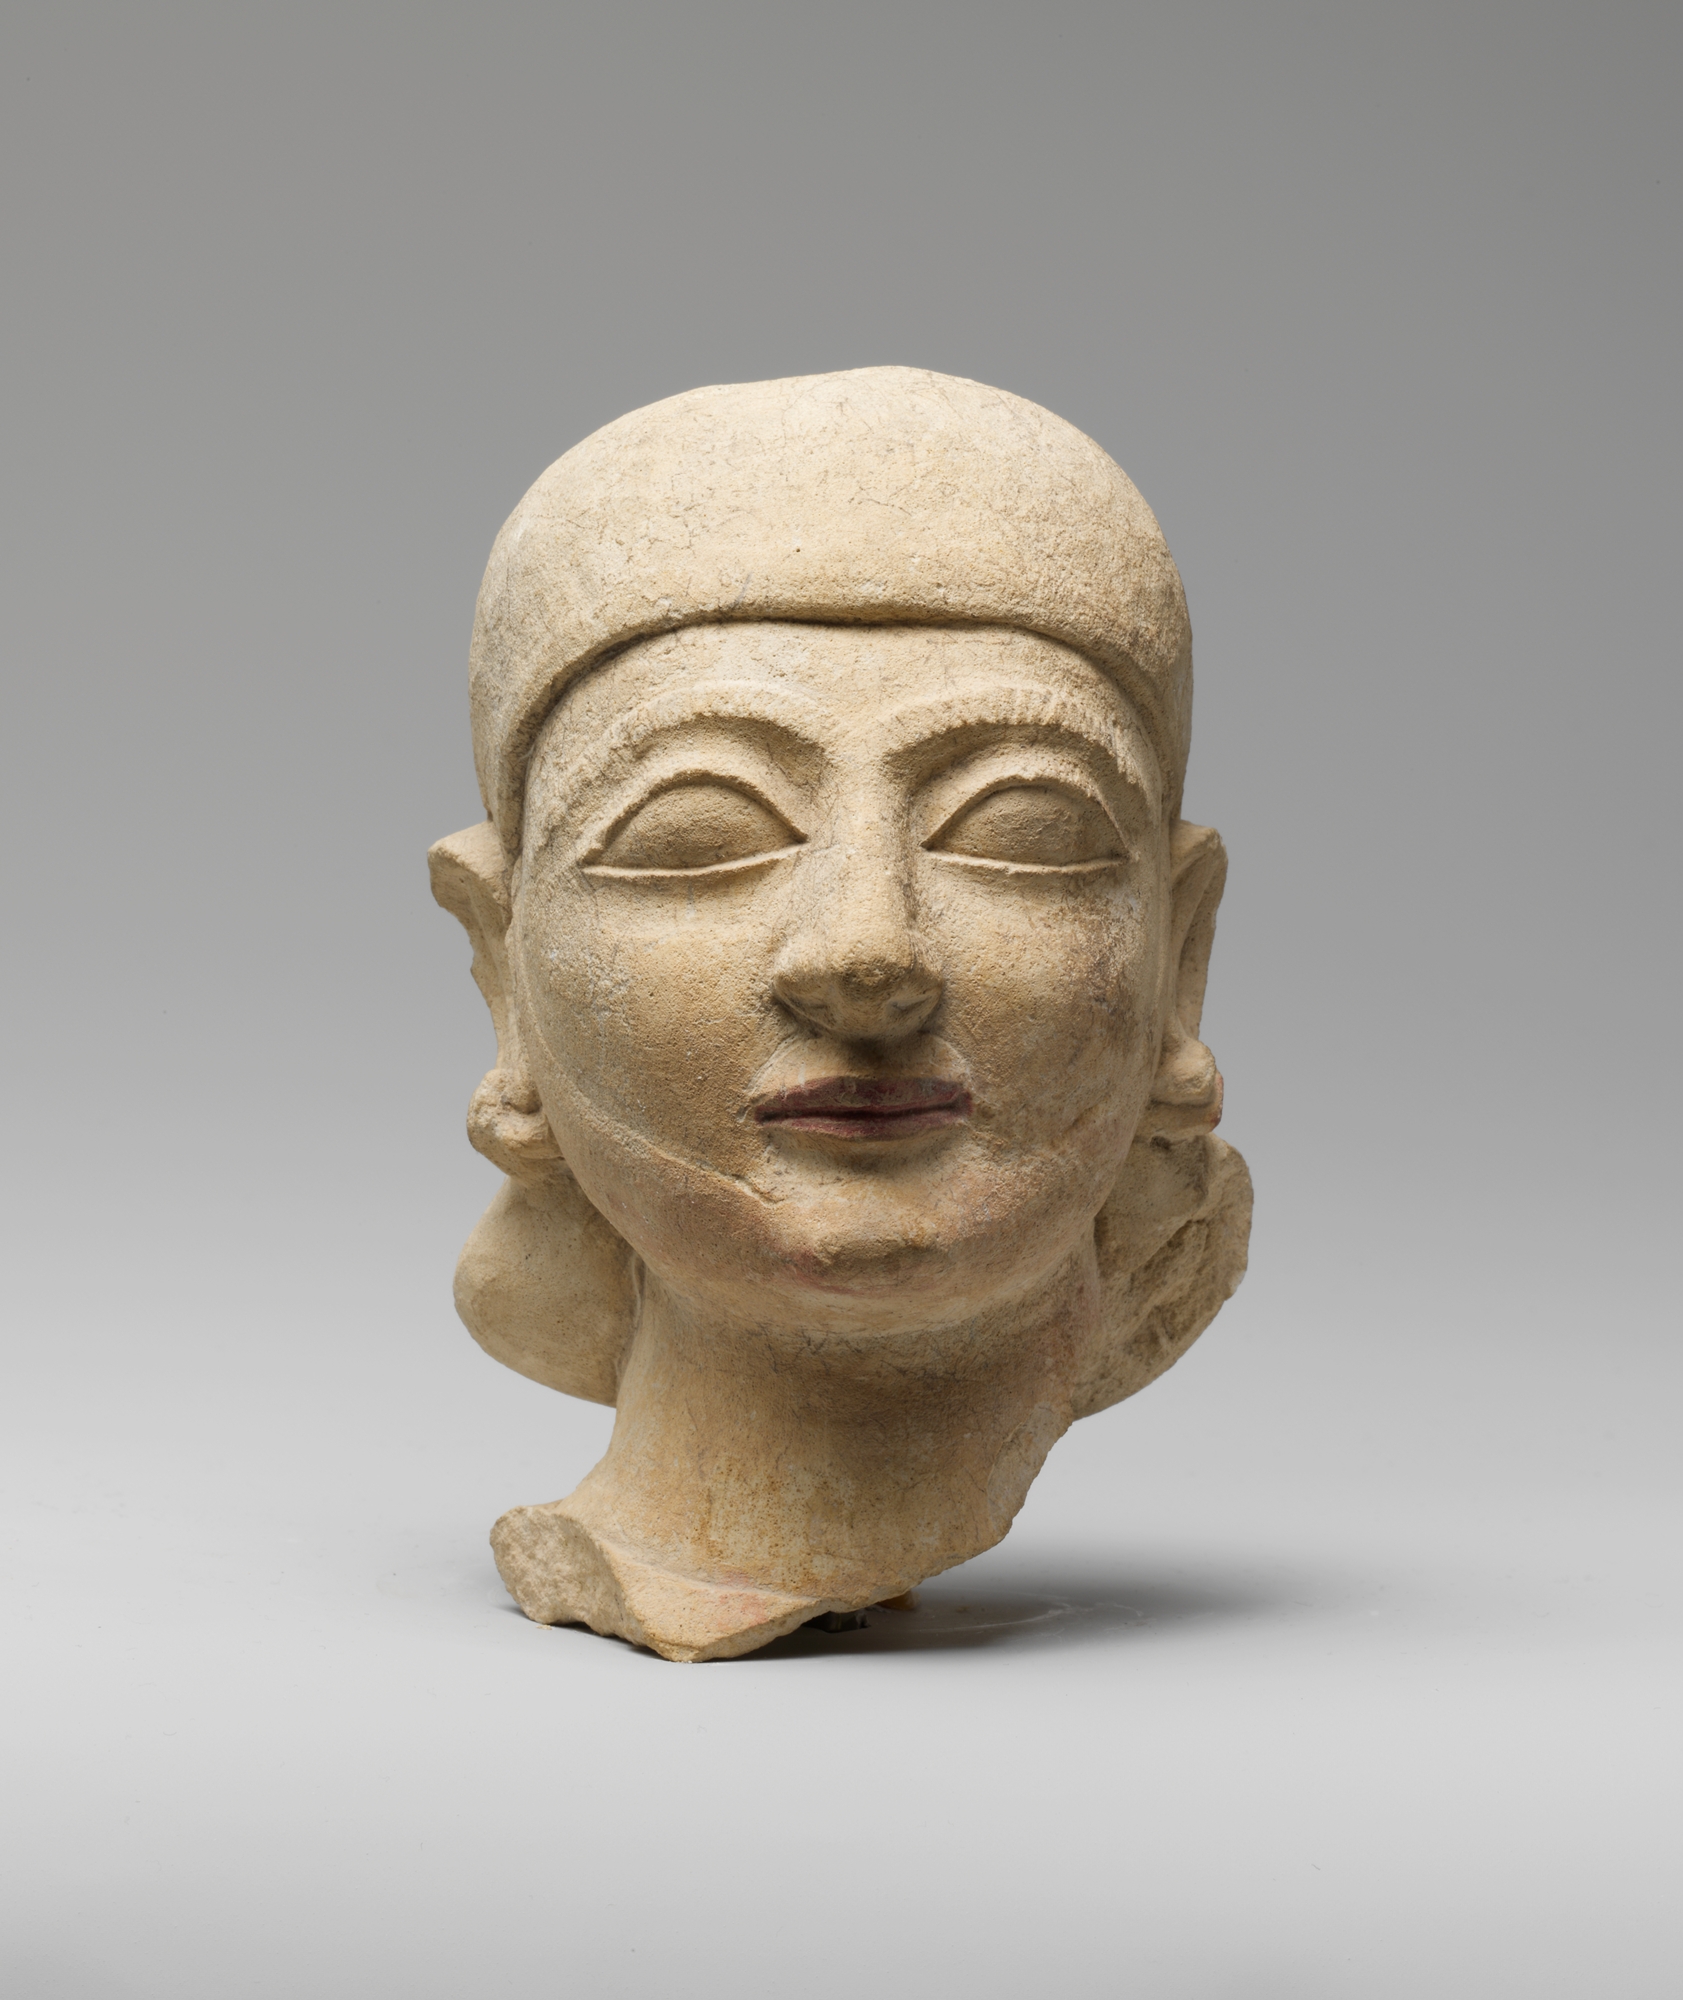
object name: head, male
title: Limestone head of a man with a plain headdress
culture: cypriot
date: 600-568 BCE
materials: limestone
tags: heads,men